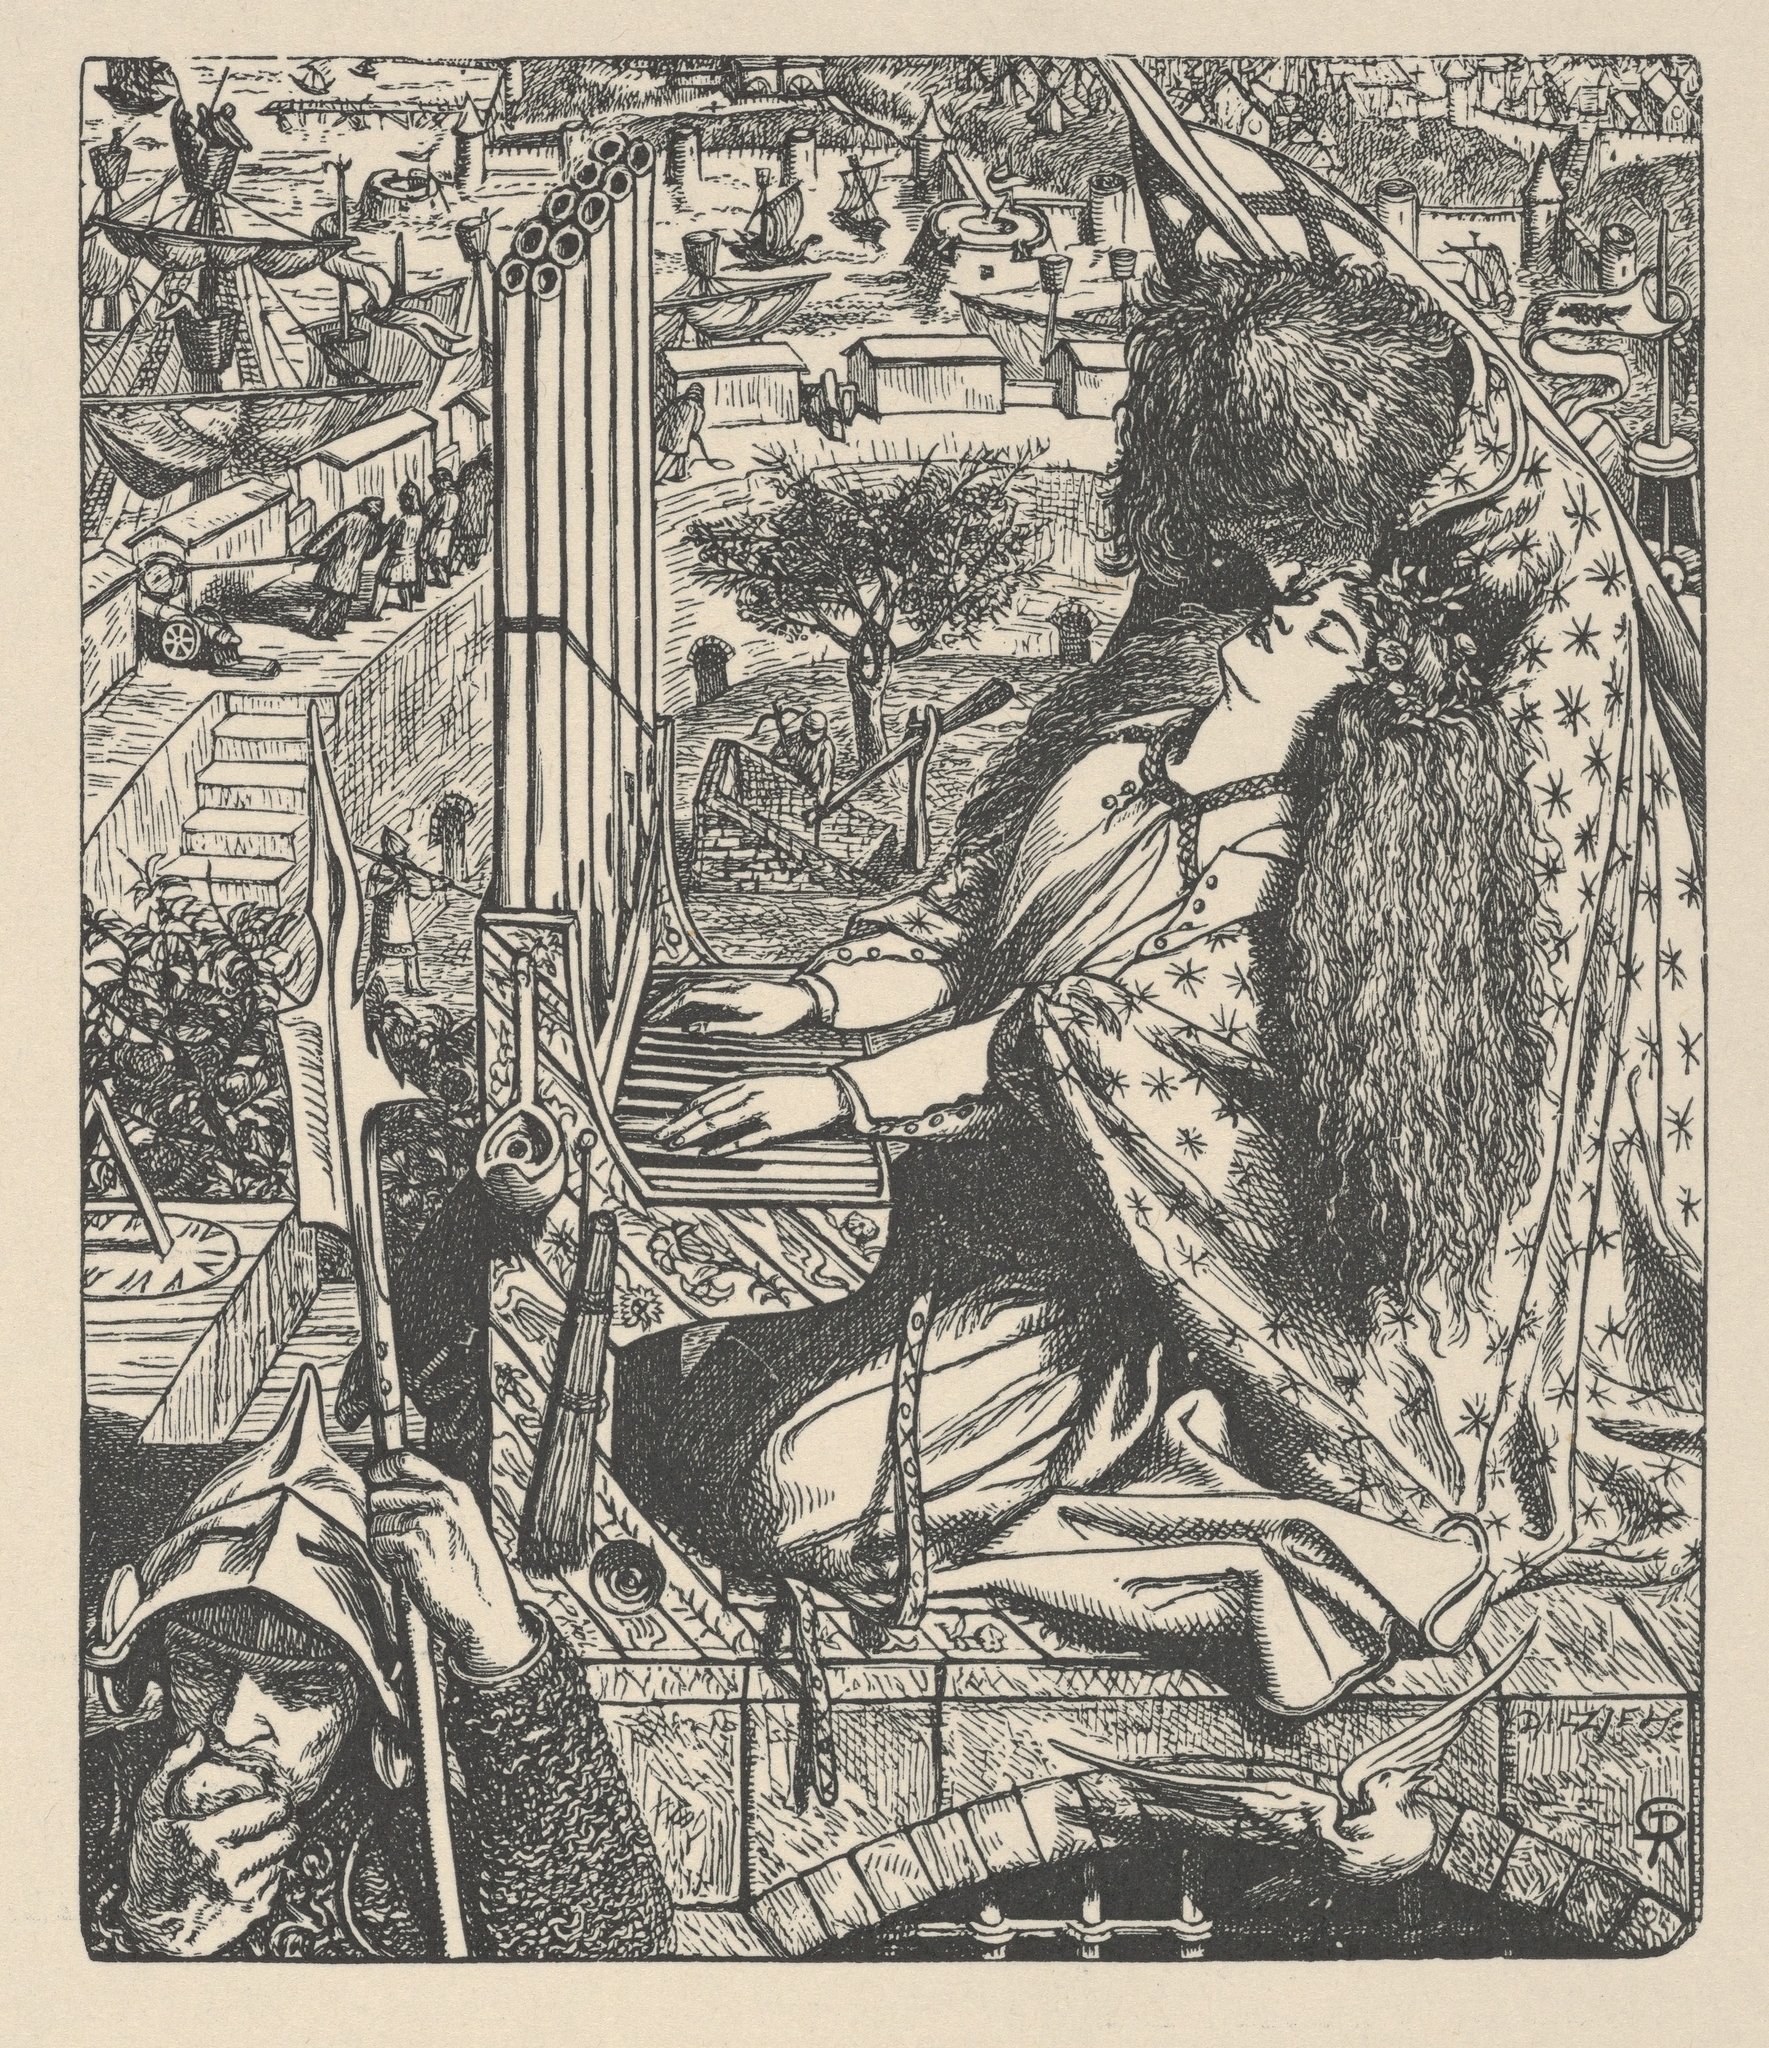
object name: print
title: St. Cecily / Cecilia (Illustration for The Palace of Art in Tennyson's Poems, New York, 1903)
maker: dante gabriel rossetti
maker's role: artist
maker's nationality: british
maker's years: 1828-1882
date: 1857-1903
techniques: engraving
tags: musical instruments,men,women,saints